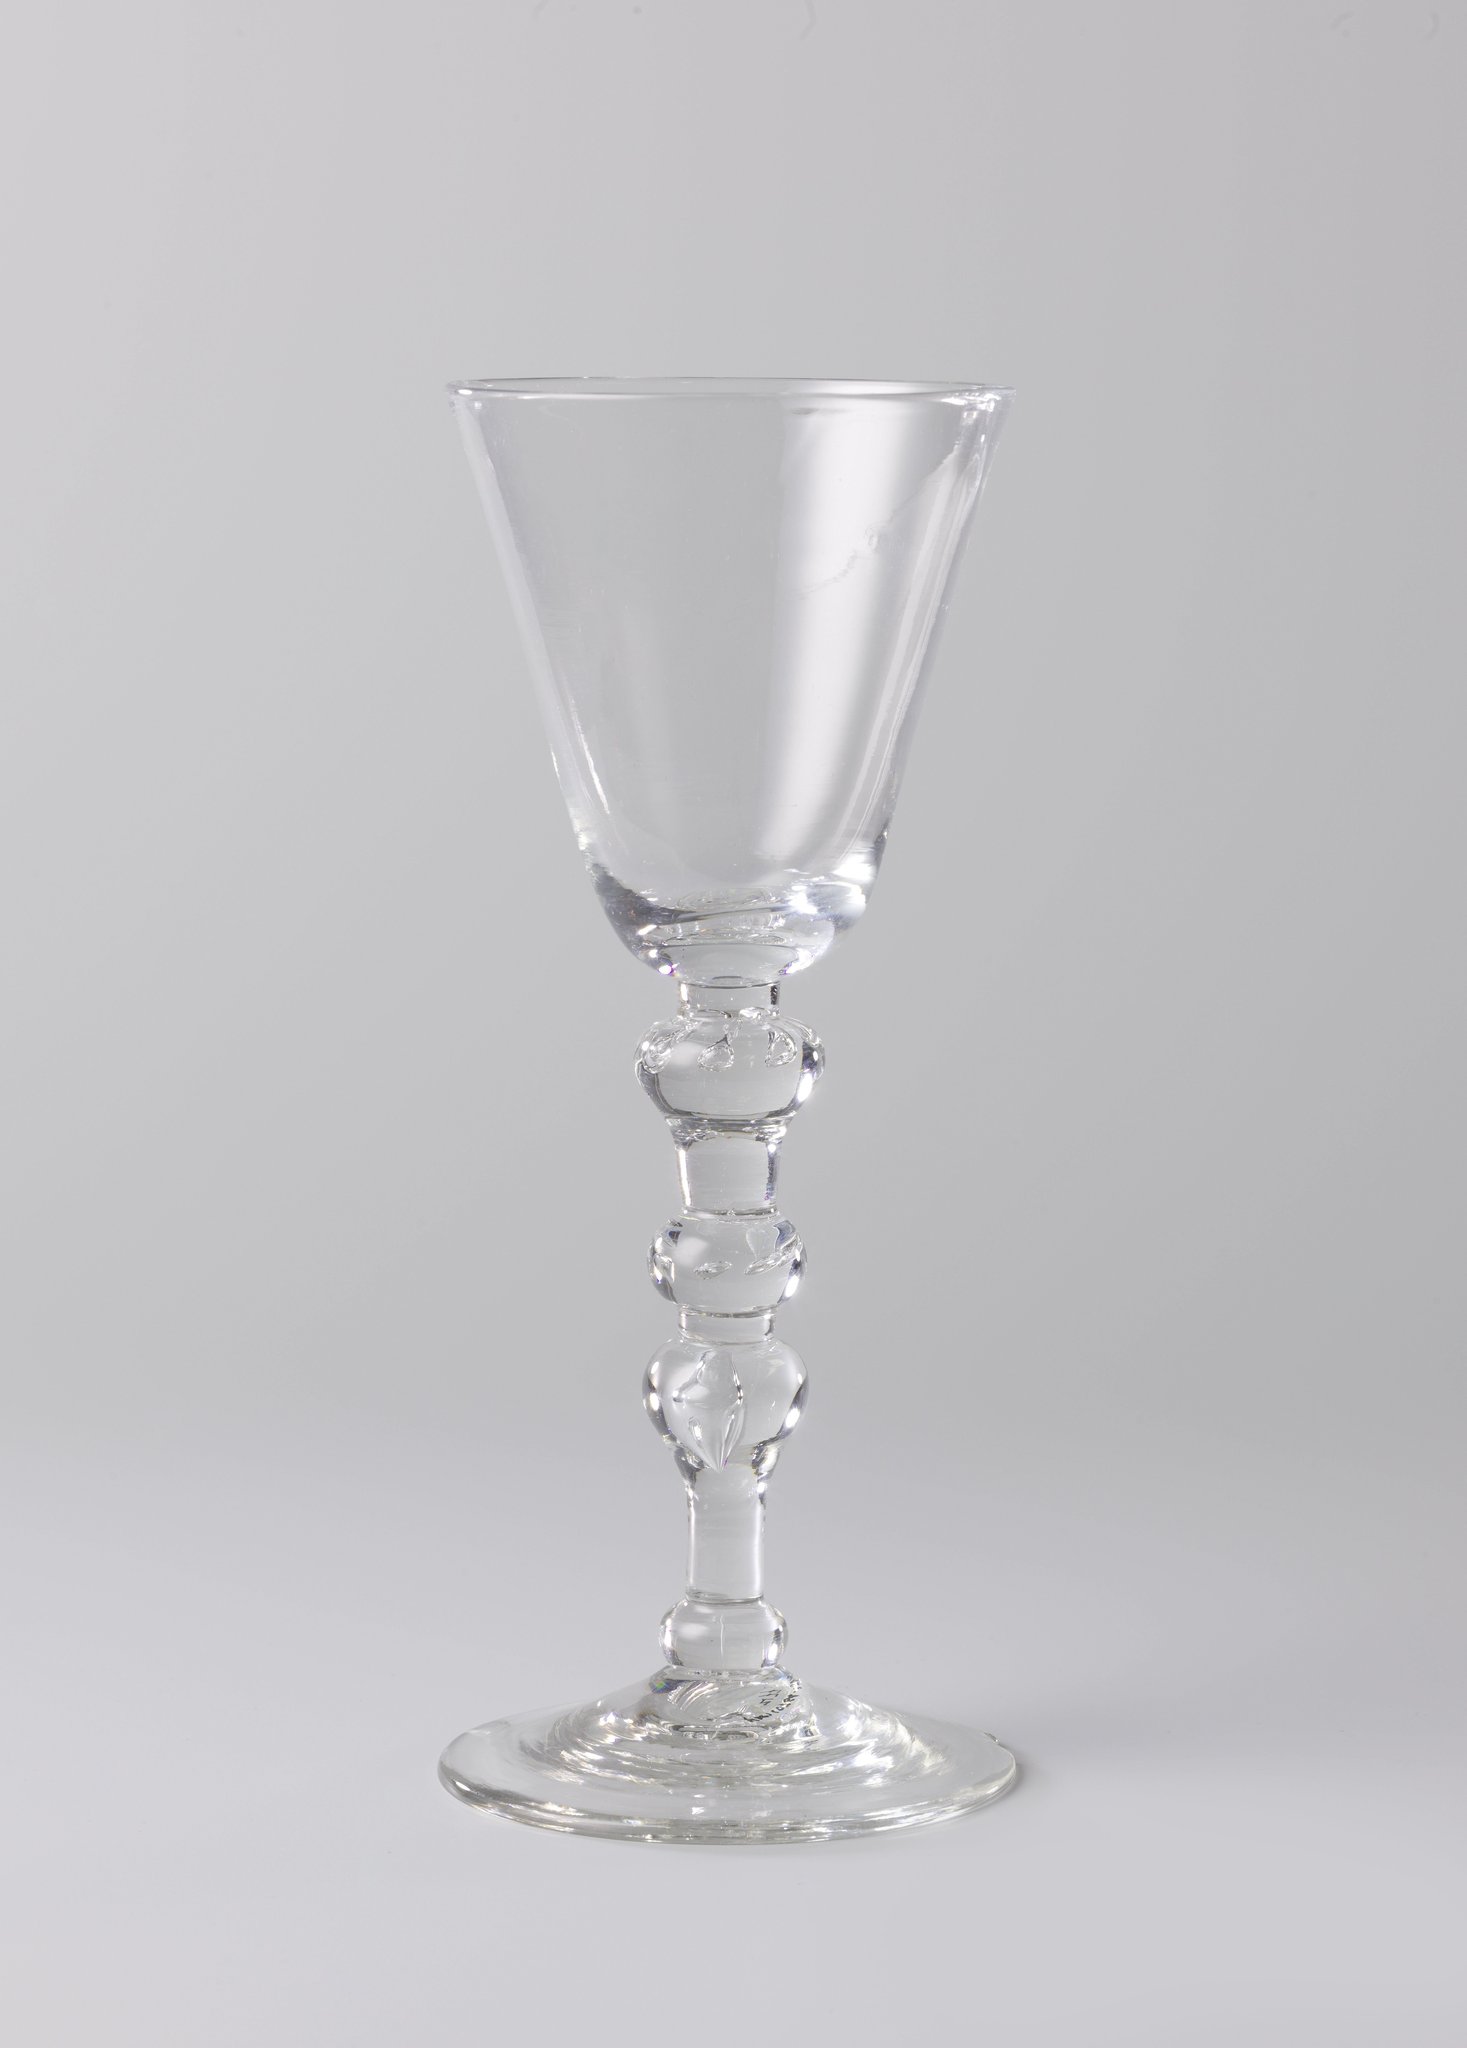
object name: goblet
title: Kelkglas met trechtervormig kelk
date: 1750-1775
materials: glass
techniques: glassblowing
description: Kelkglas op conische voet. Balustroïde stam met ingestoken luchtbellen. Trechtervormige, aan de onderzijde afgeronde kelk.